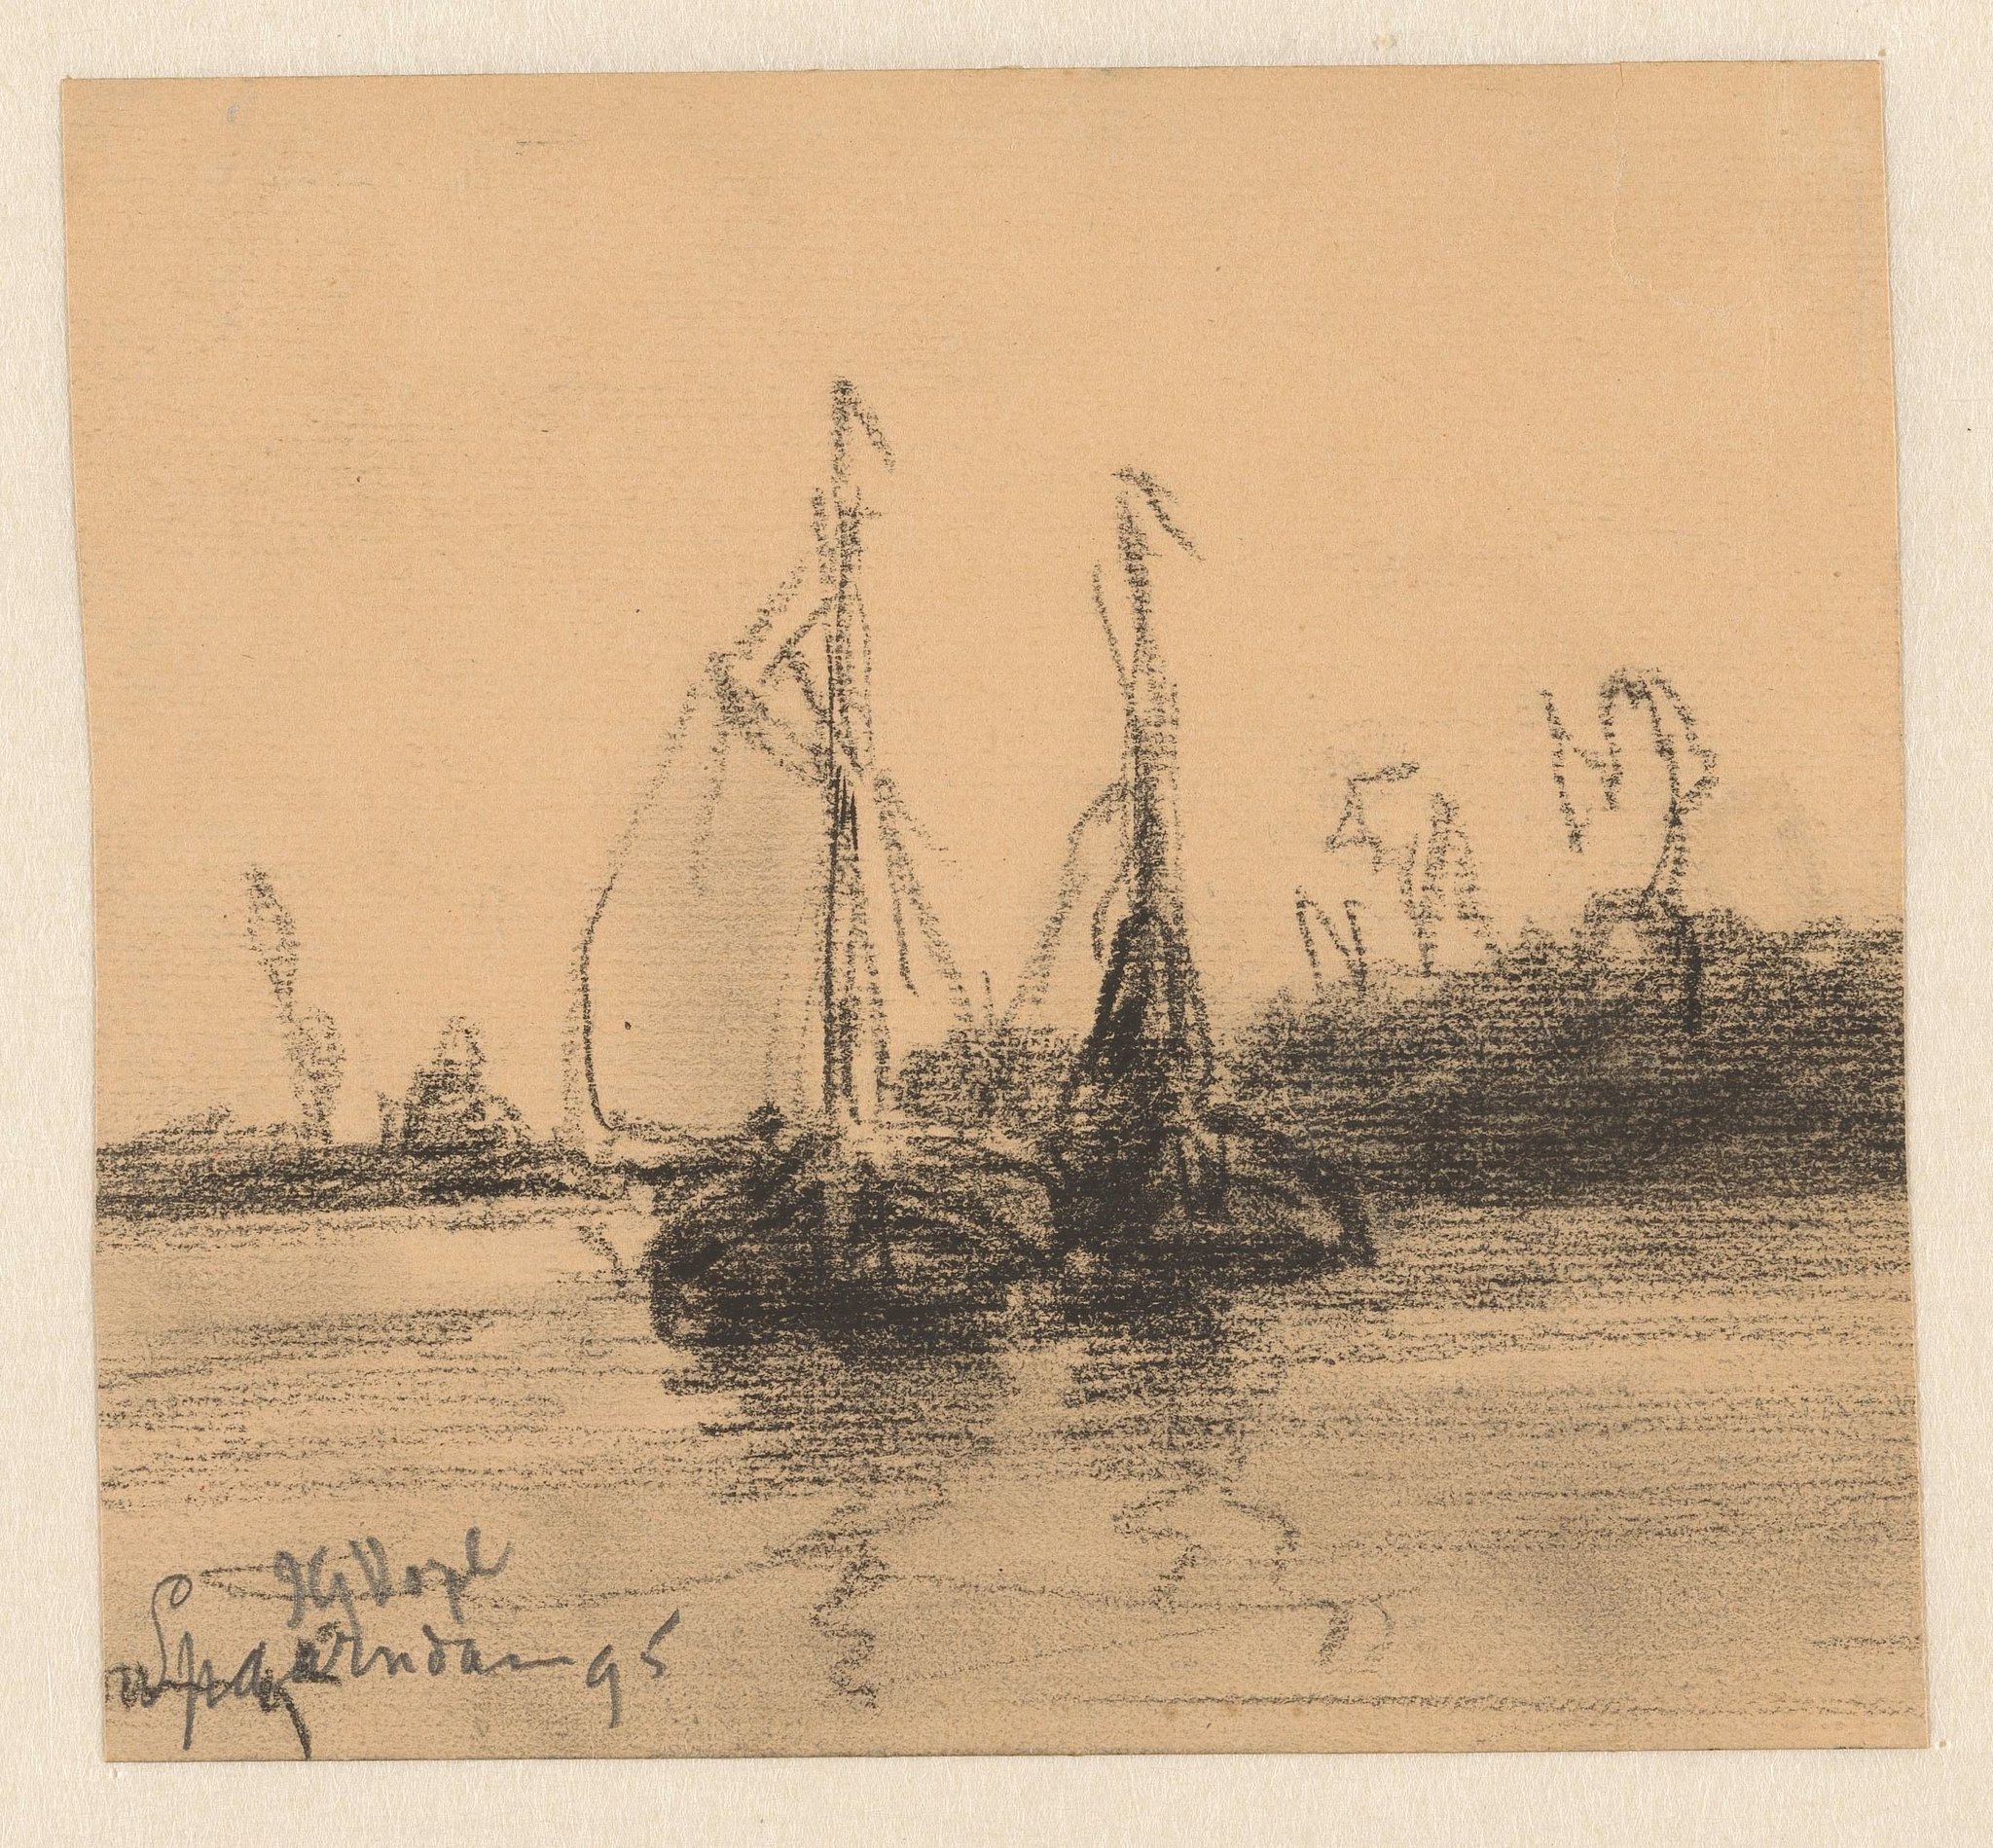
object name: drawing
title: Twee zeilschepen bij Spaarndam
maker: johannes gijsbert vogel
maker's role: draughtsman, painter, print maker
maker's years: 1828-1915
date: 1895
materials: chalk, paper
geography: spaarndam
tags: sailing-ship, sailing-boat, river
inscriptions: date